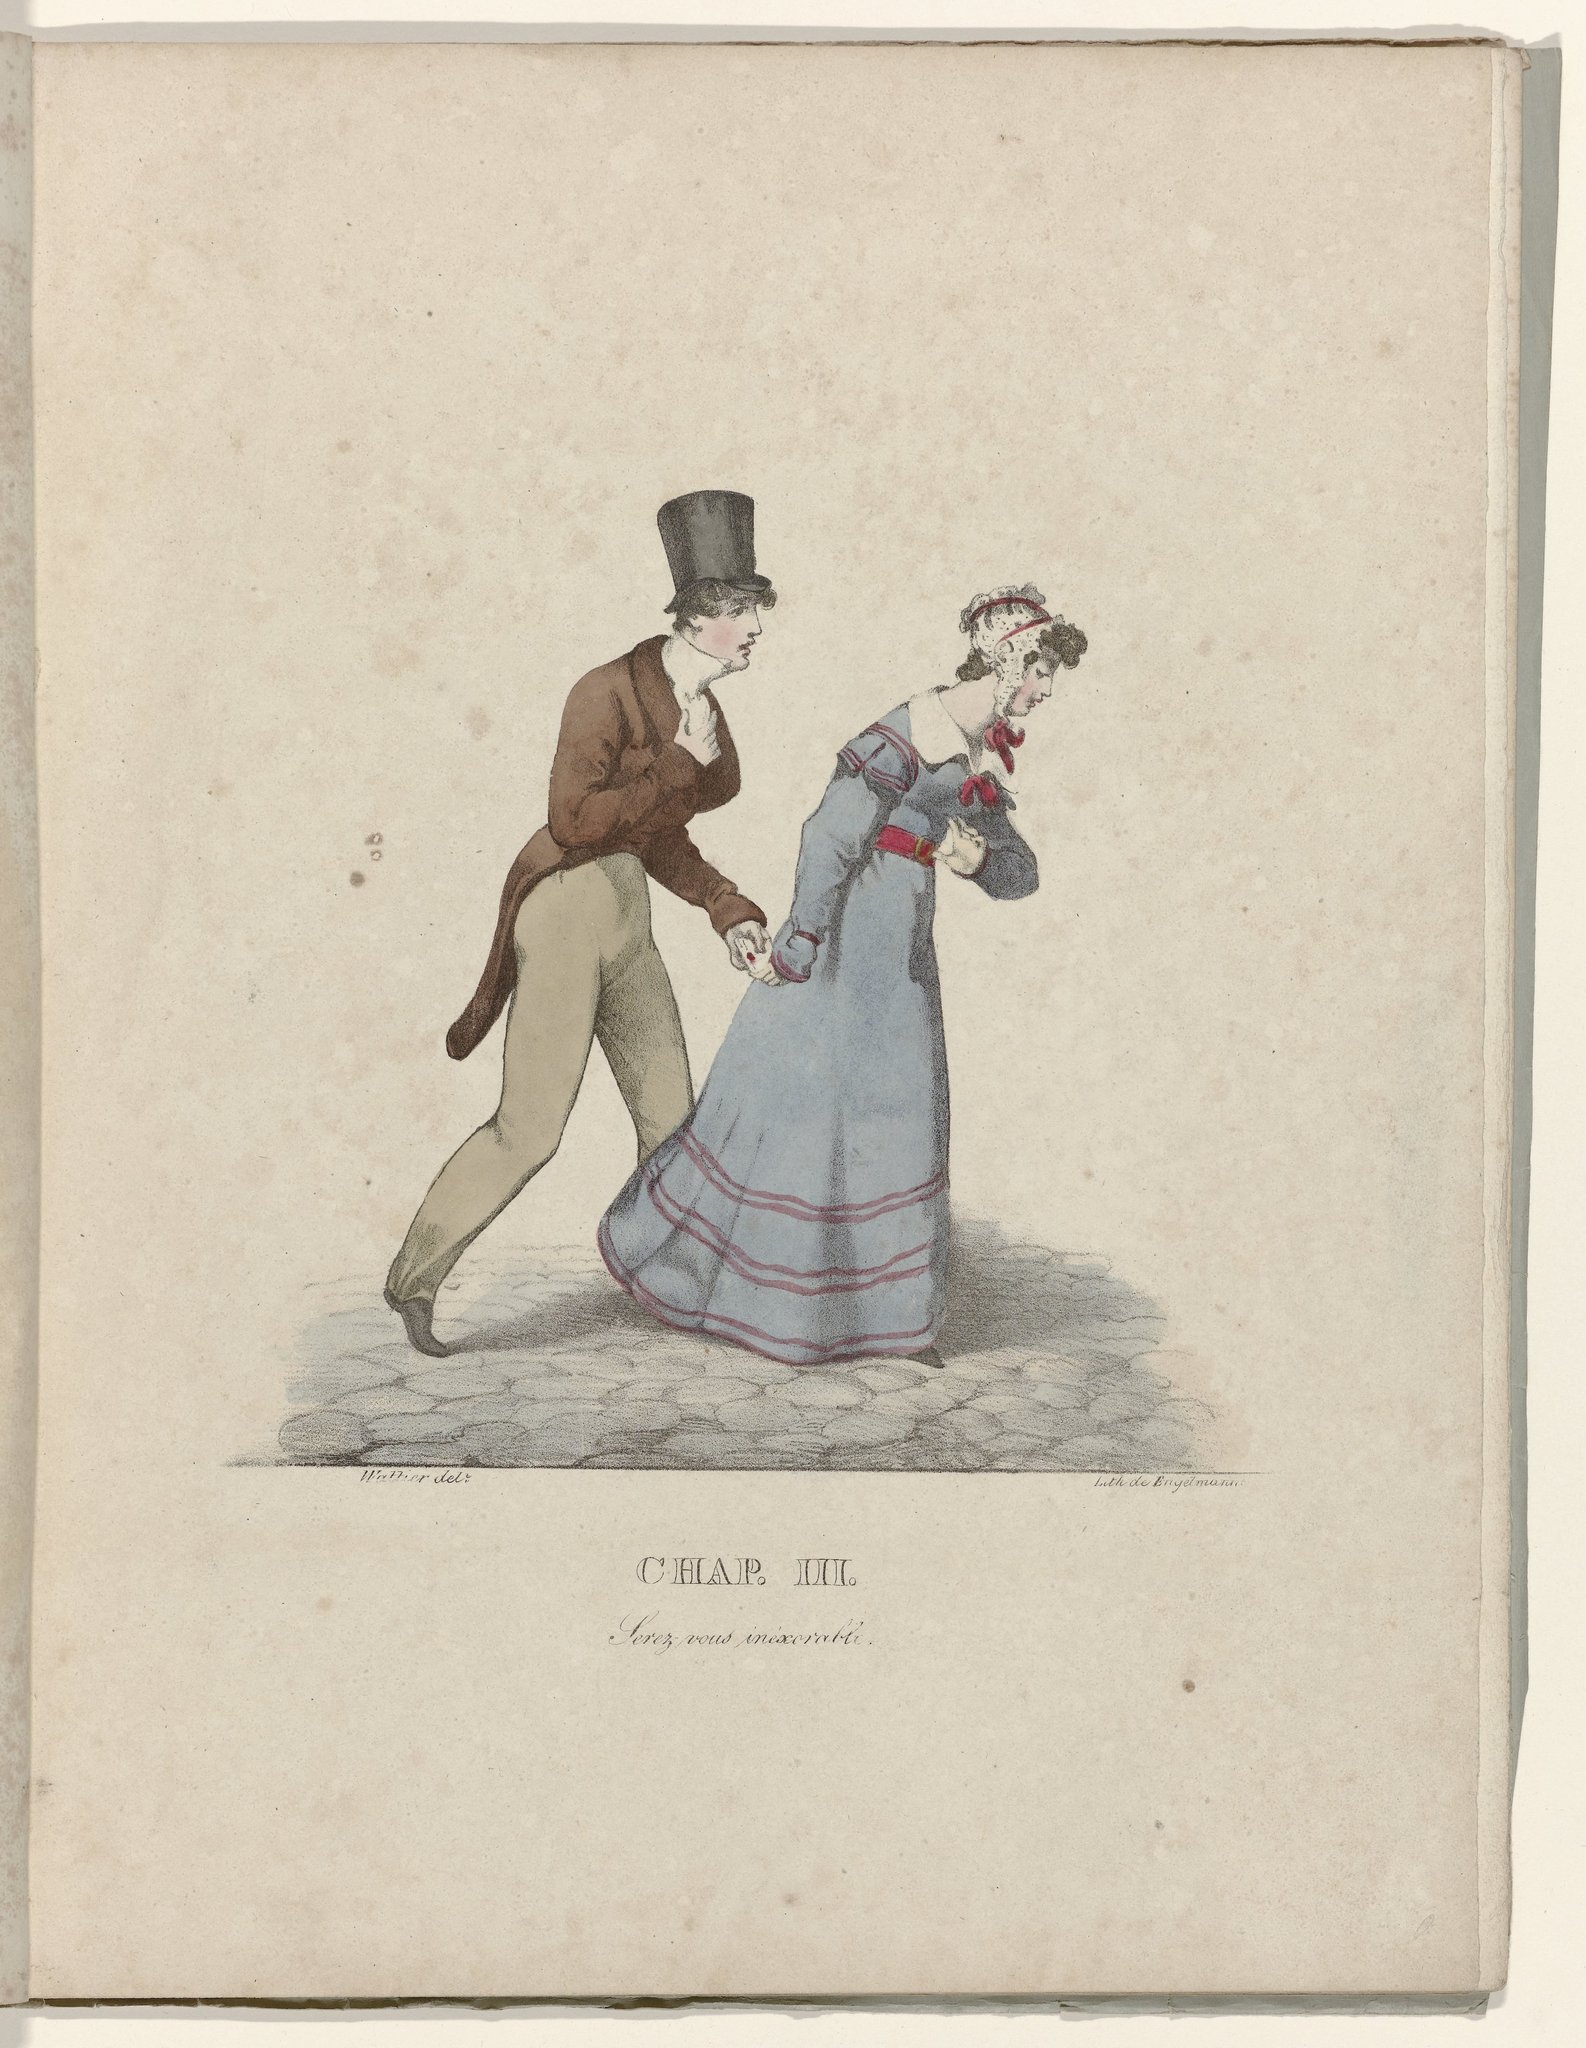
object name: fashion print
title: La Né d'une Modiste, 1828 : Chap. III: Serez-vous inexorable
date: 1828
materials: paper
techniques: hand coloring, lithograph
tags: fashion plates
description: Jongedame , hand in hand lopend met jongeman met hoge hoed op, naar rechts